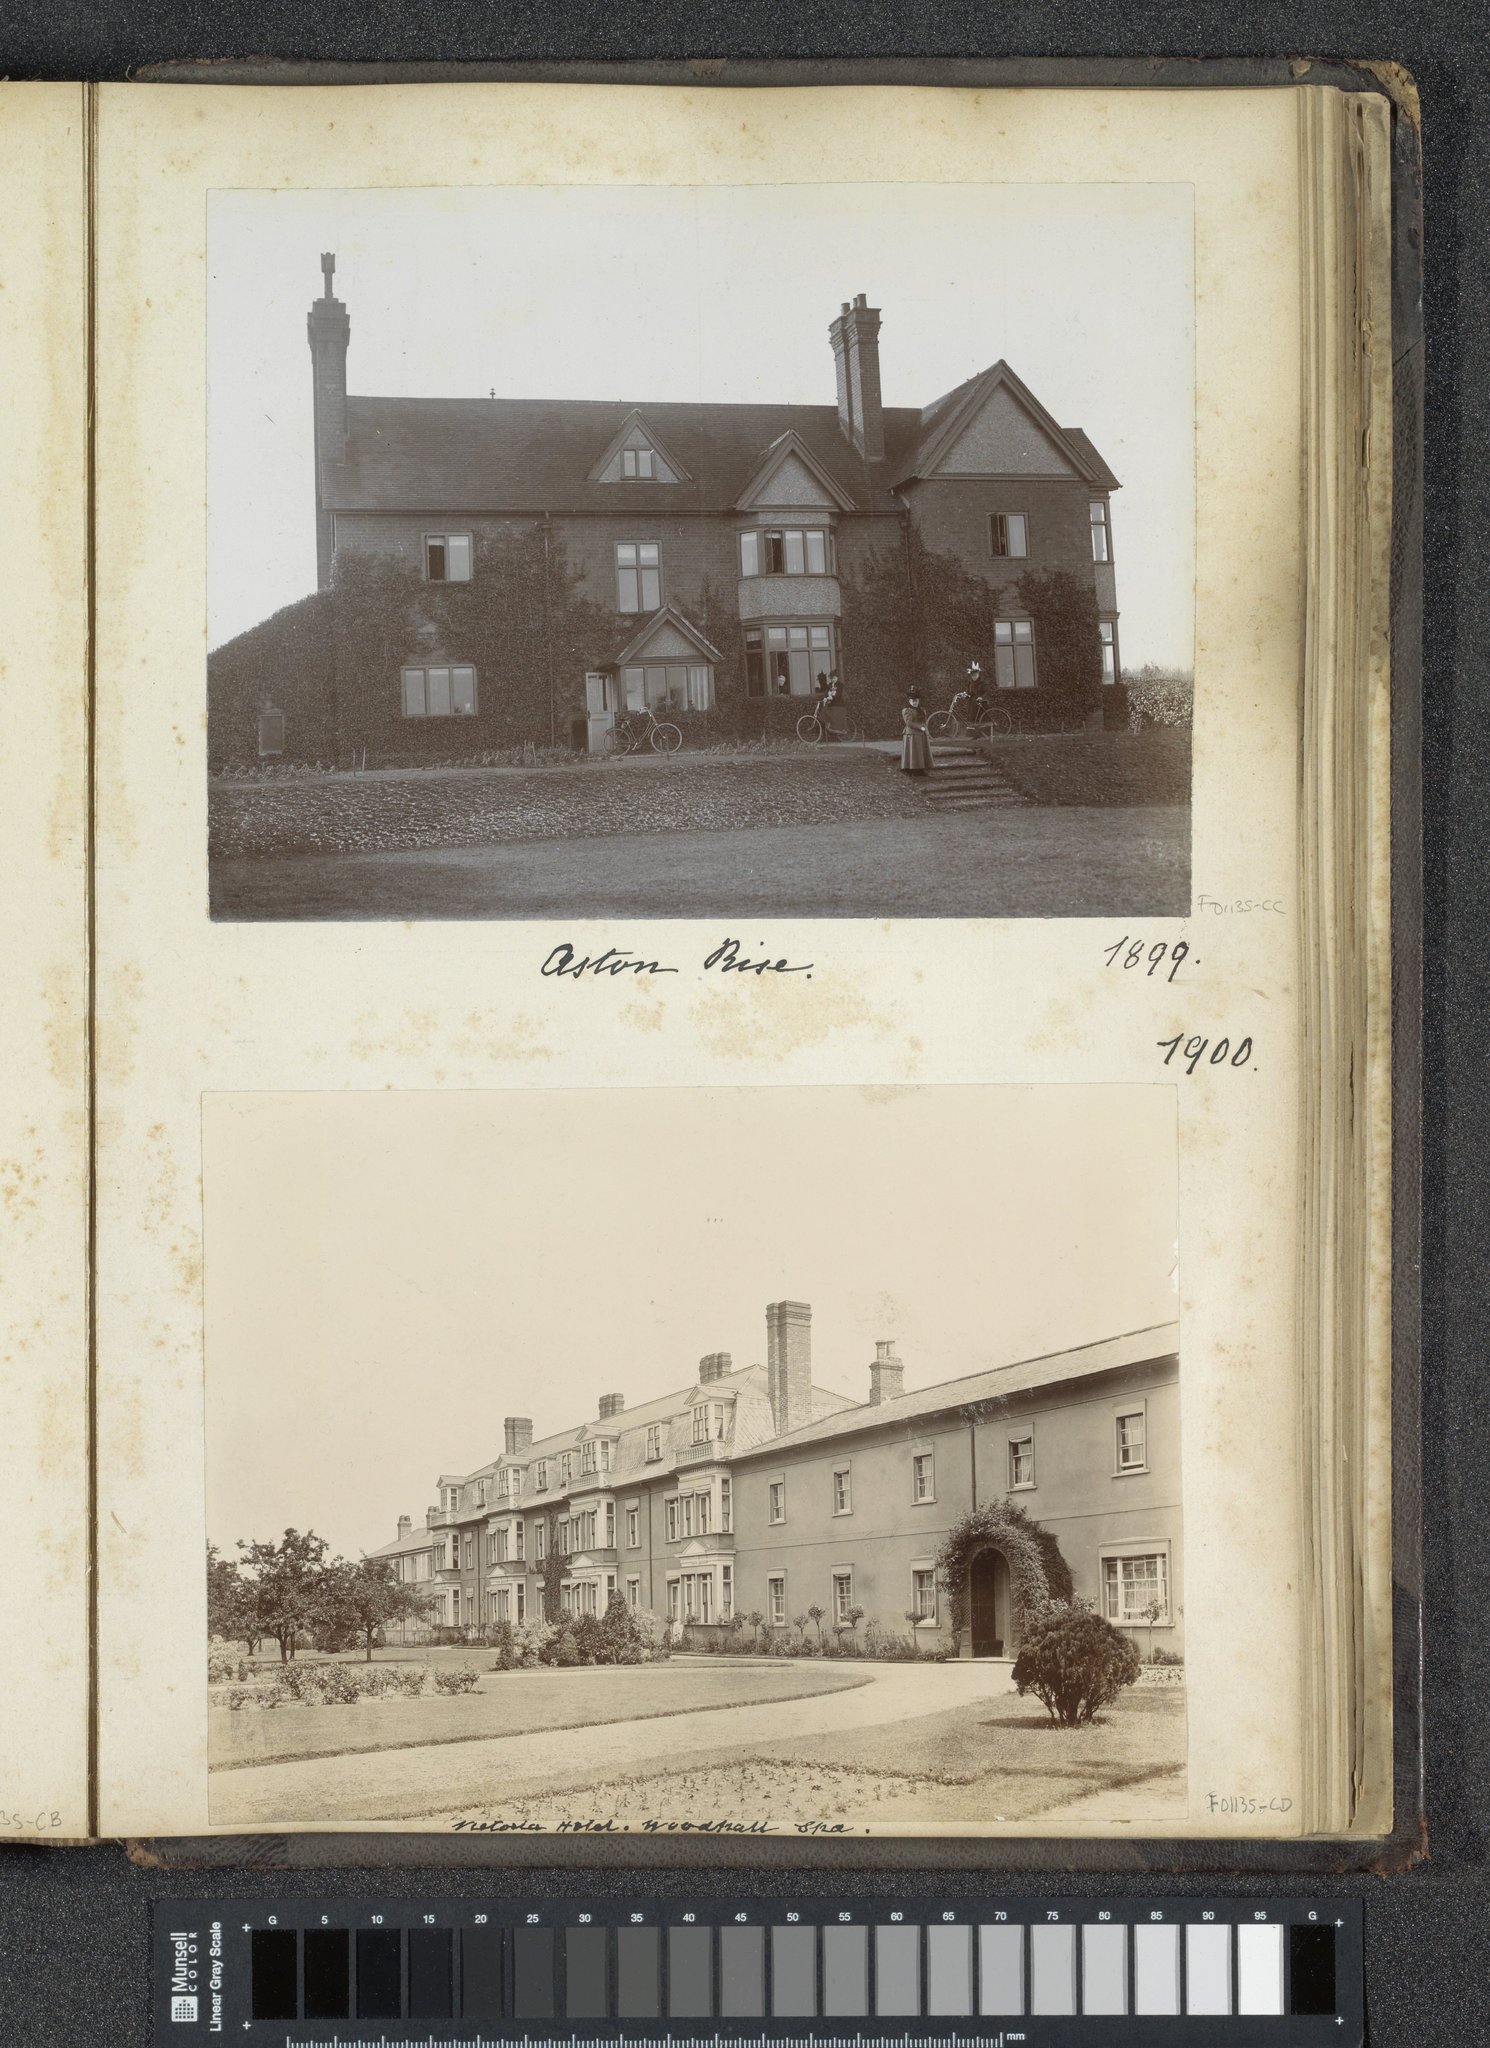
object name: album leaf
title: Exterieur van Victoria Hotel in Woodhall Spa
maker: Anonymous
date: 1900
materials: paper, photographic support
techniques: gelatin silver print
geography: woodhall spa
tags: façade (of house or building), hotel, hostelry, inn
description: Onderdeel van Reisalbum met foto's van bezienswaardigheden in Engeland en Frankrijk.